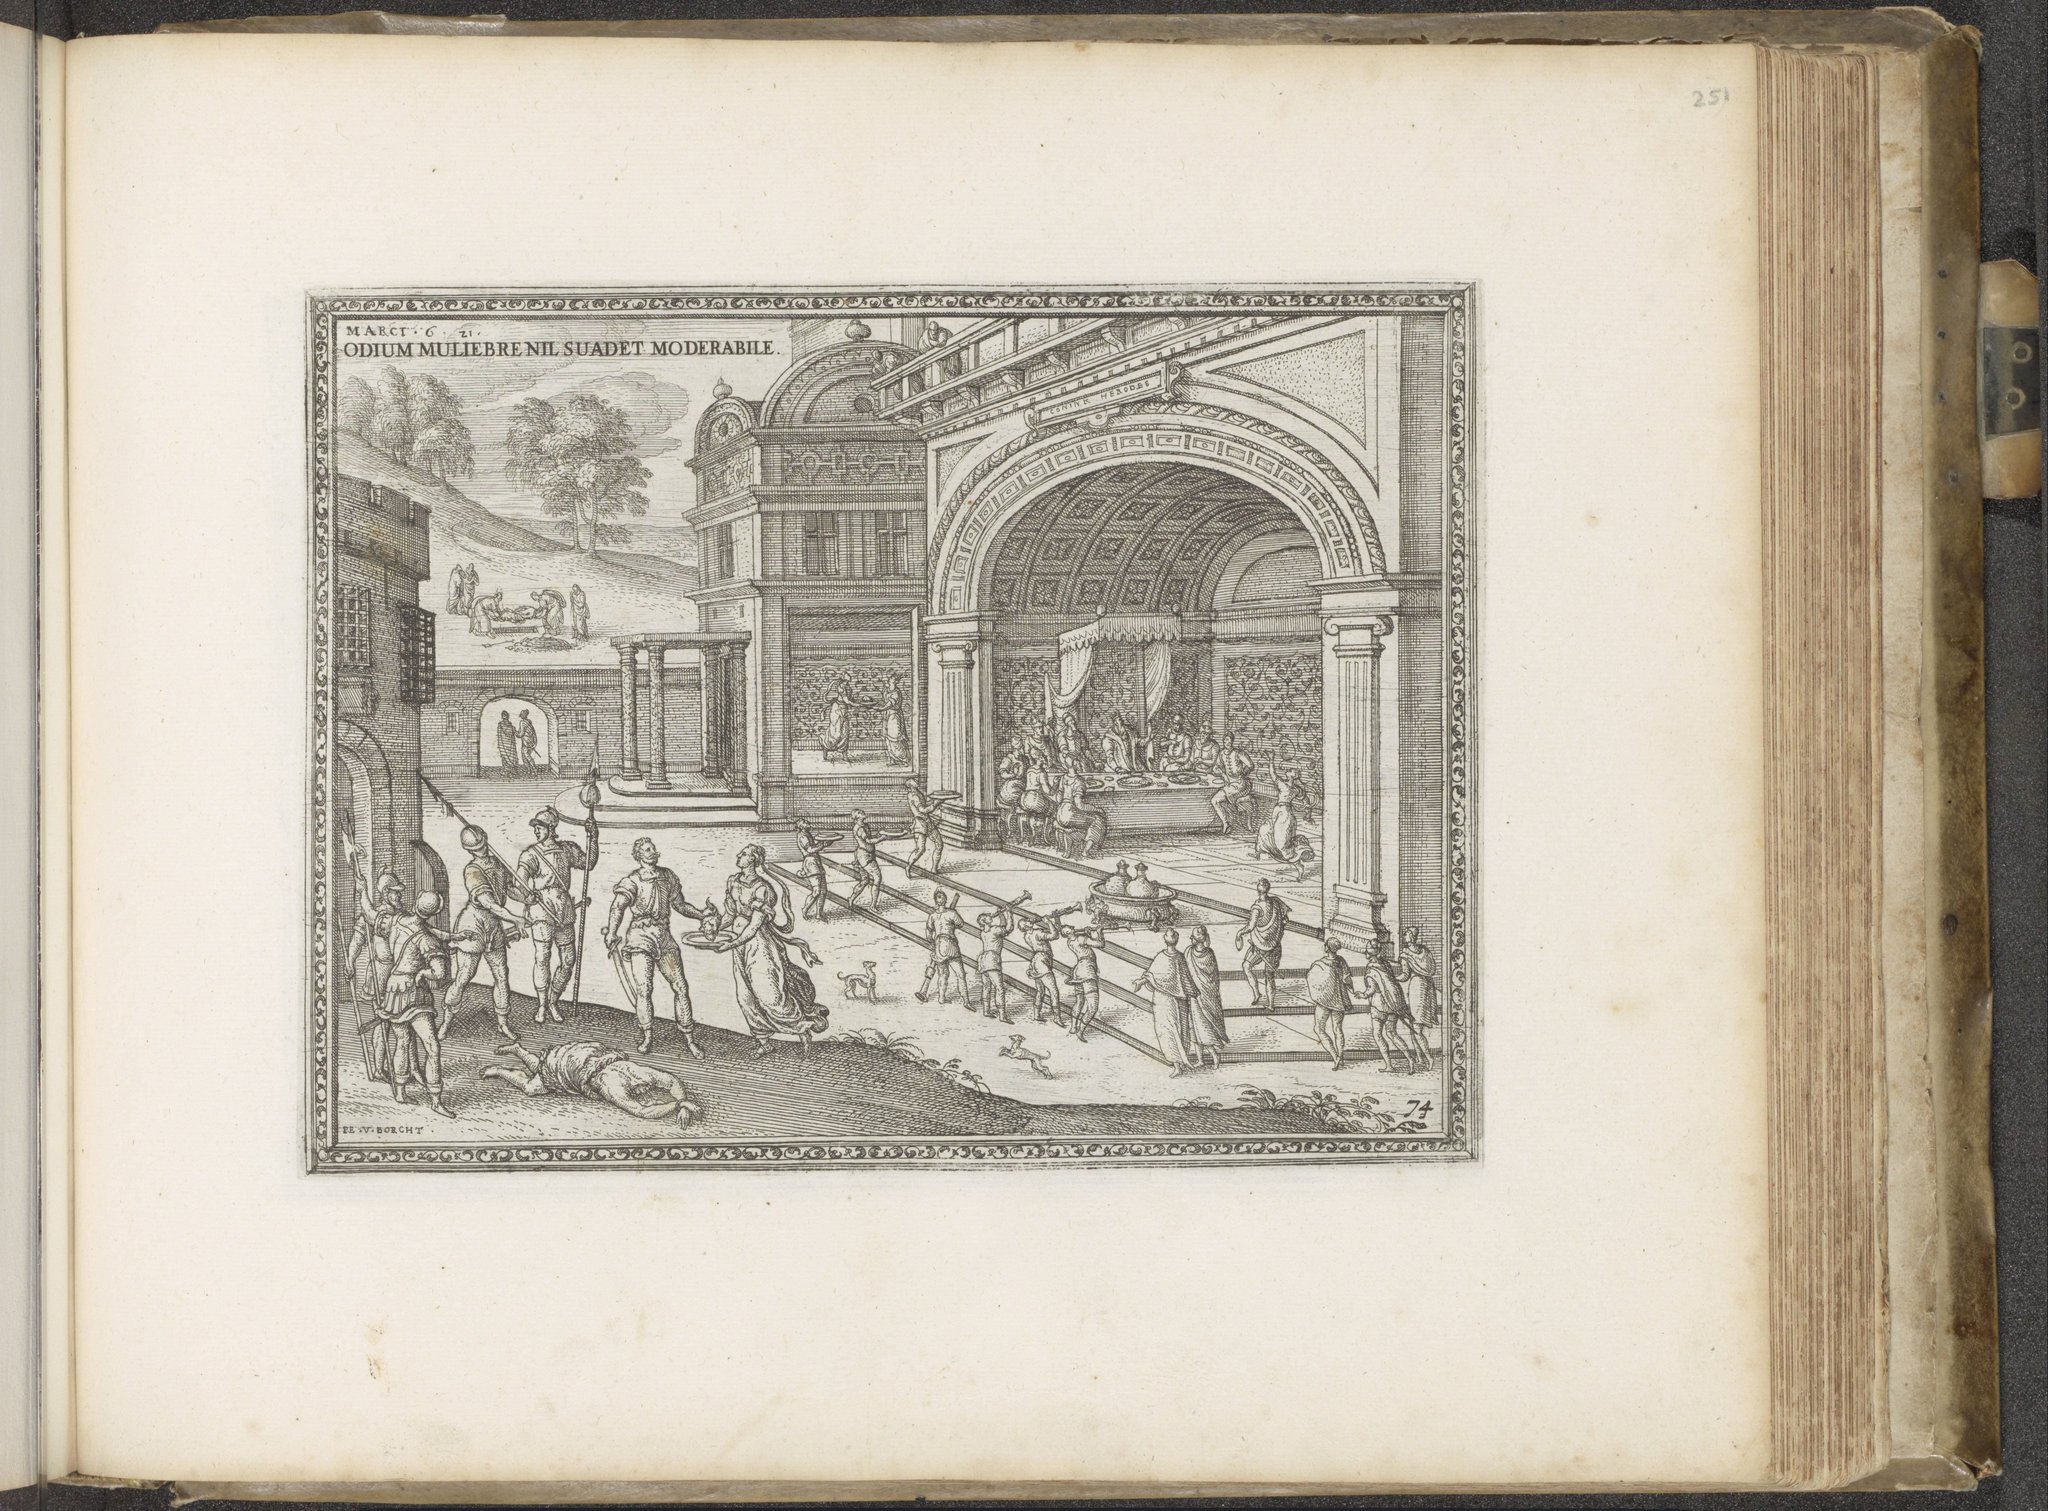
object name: album leaf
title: Imagines et figurae bibliorum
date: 1582-1593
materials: paper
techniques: etching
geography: amsterdam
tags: lamentation and burial of john the baptist, salome is given the head of john the baptist by the executioner, salome gives the head of john the baptist to her mother, salome dancing during the banquet of herod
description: Verschillende scènes over de dood van Johannes de Doper. Rechts danst Salome bij de maaltijd van Herodes. Links op de voorgrond ligt de onthoofde Johannes de Doper, zijn handen gebonden. De beul biedt het hoofd aan aan Salome, die een schotel ophoudt. Op de achtergrond brengt Salome het hoofd aan Herodias en wordt het lichaam van Johannes begraven (Mar. 6:21). Rechtsonder het nummer dat de prent in een eerdere uitgave had: 74. De prent maakt deel uit van een album.